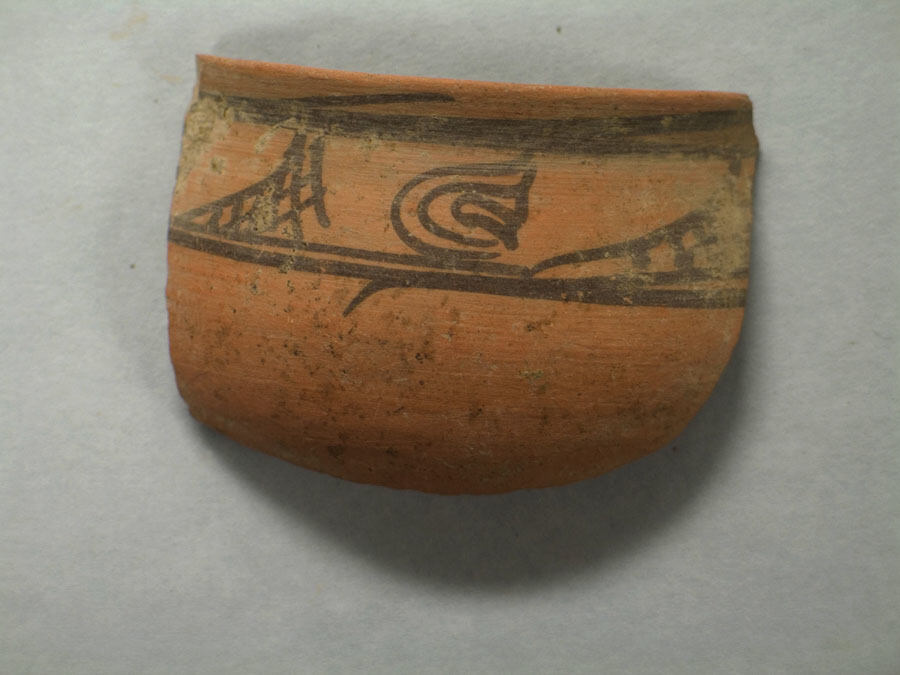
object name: shard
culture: pakistani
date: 301-500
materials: terracotta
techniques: painting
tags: gandhara